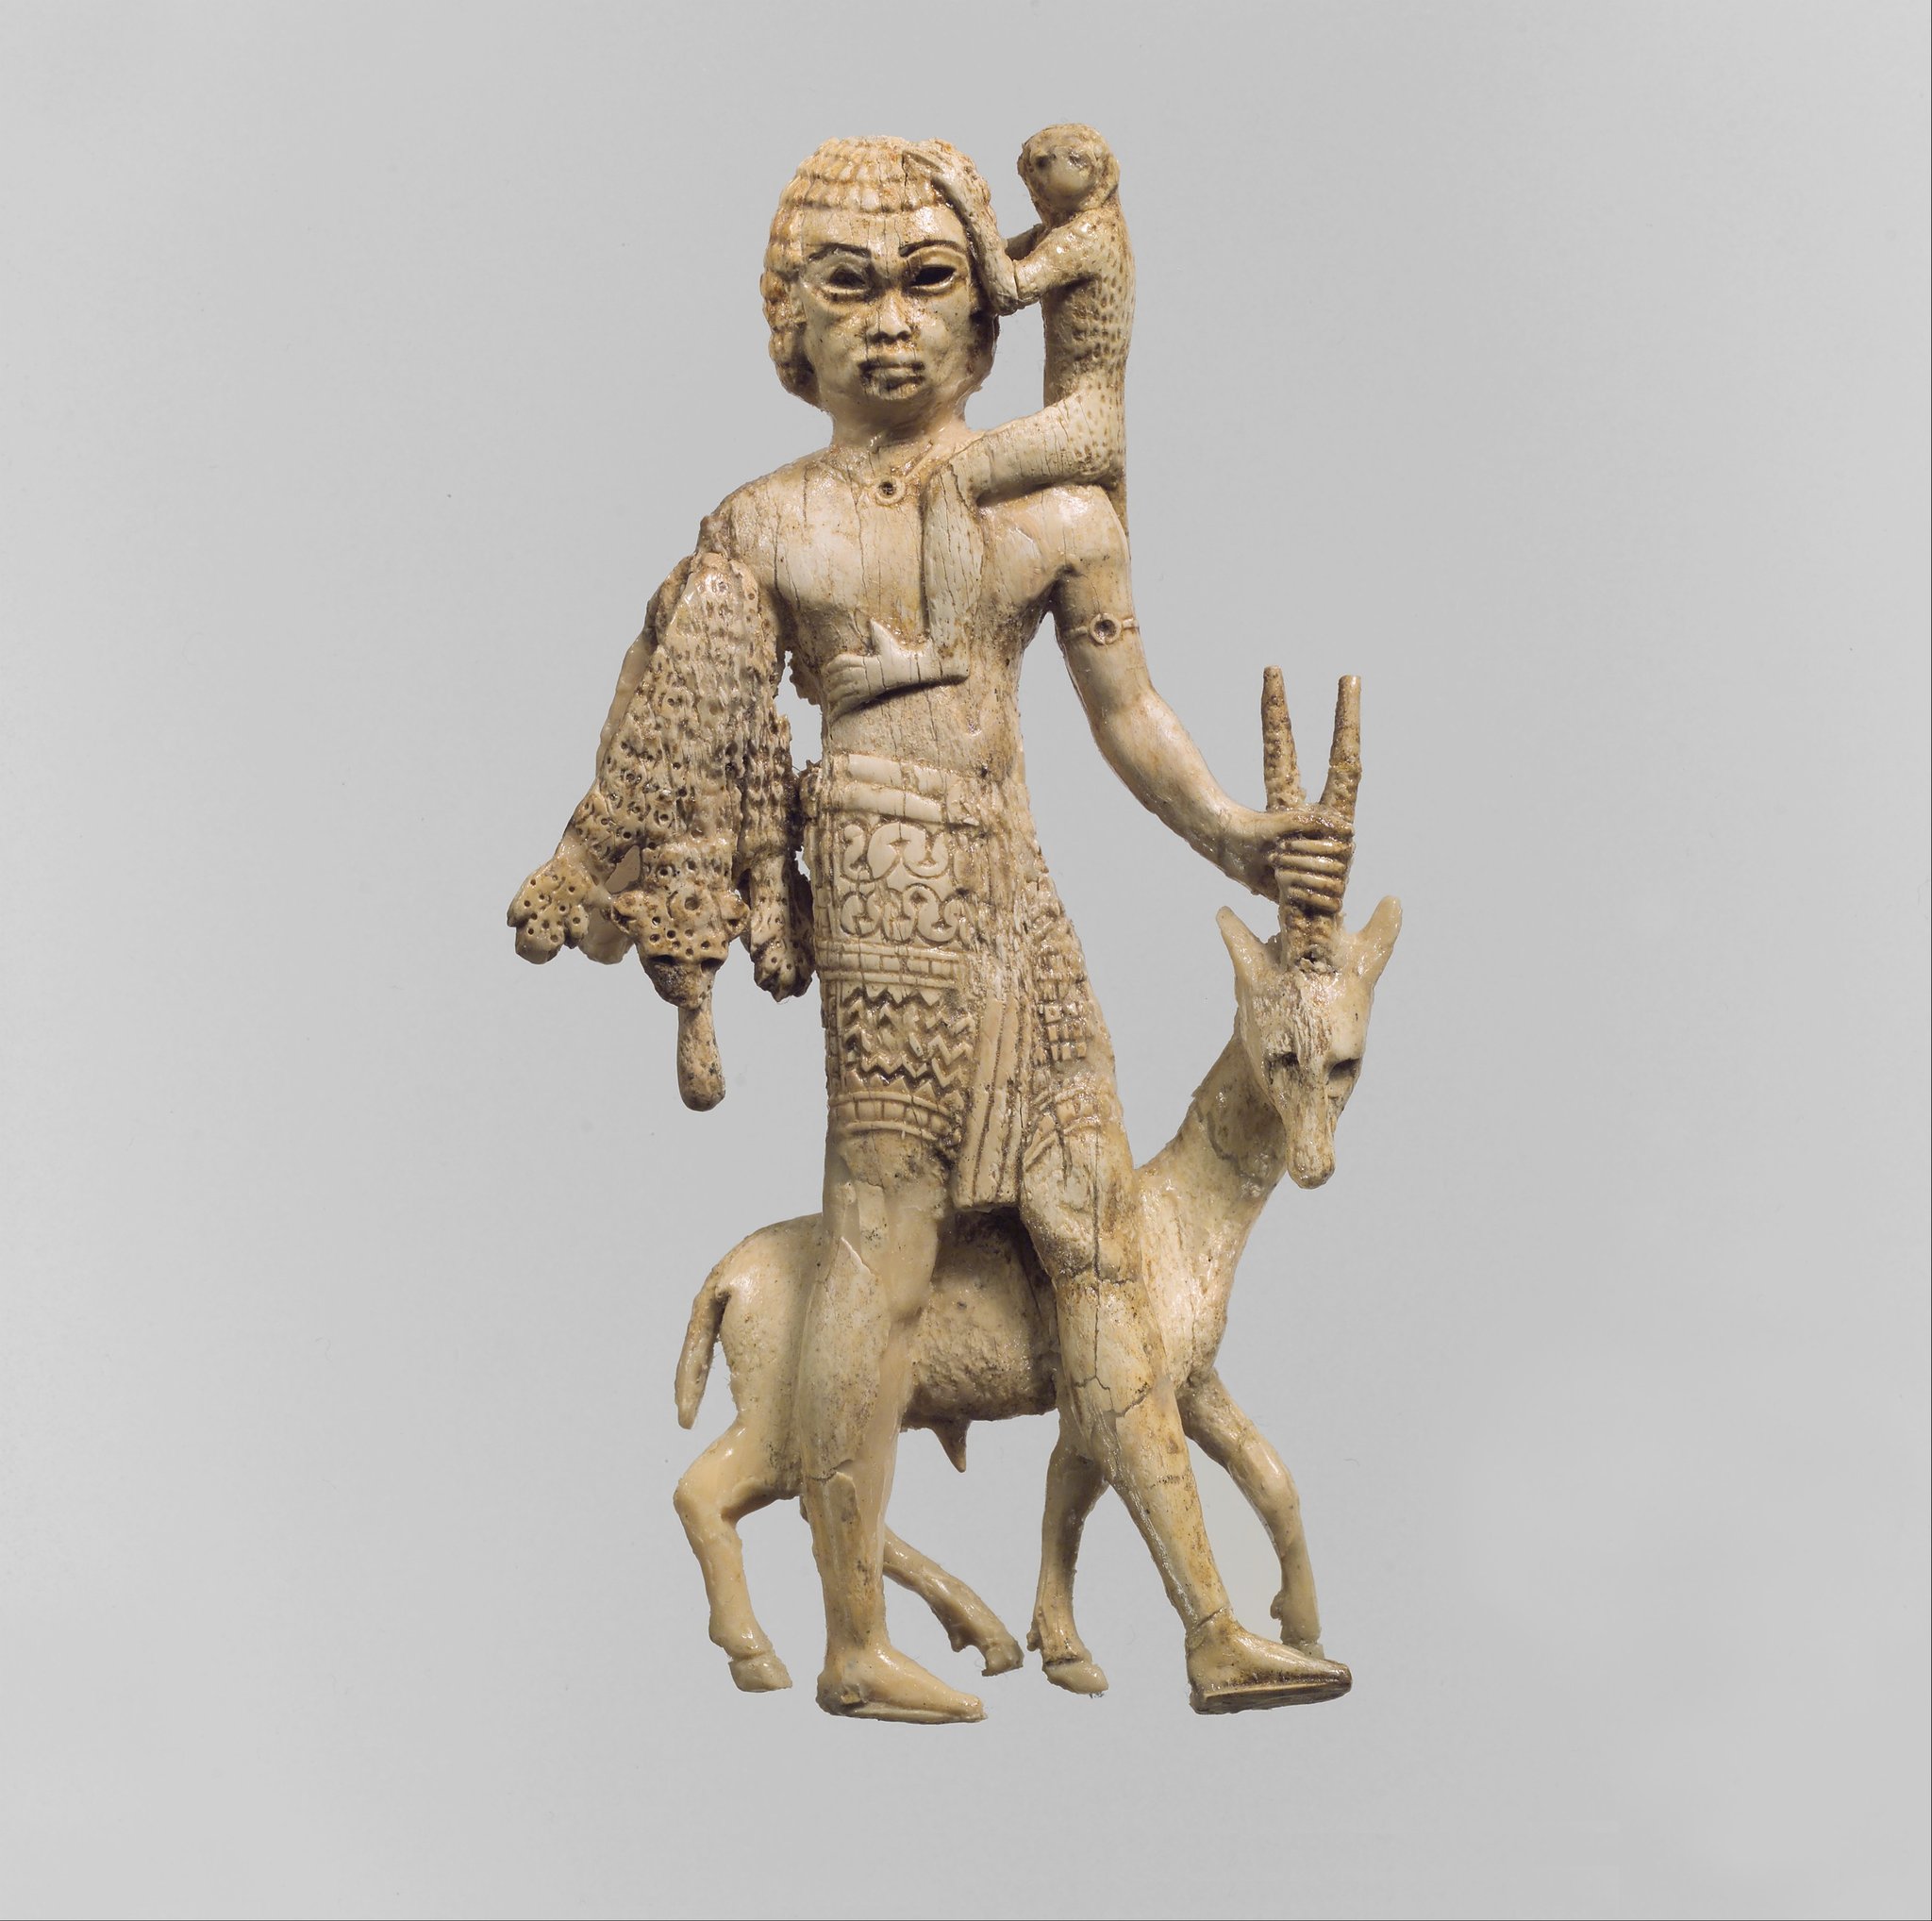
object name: sculpture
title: Figure of a man with an oryx, a monkey, and a leopard skin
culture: assyrian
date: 800-701 BCE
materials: ivory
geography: mesopotamia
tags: animals,men,monkeys